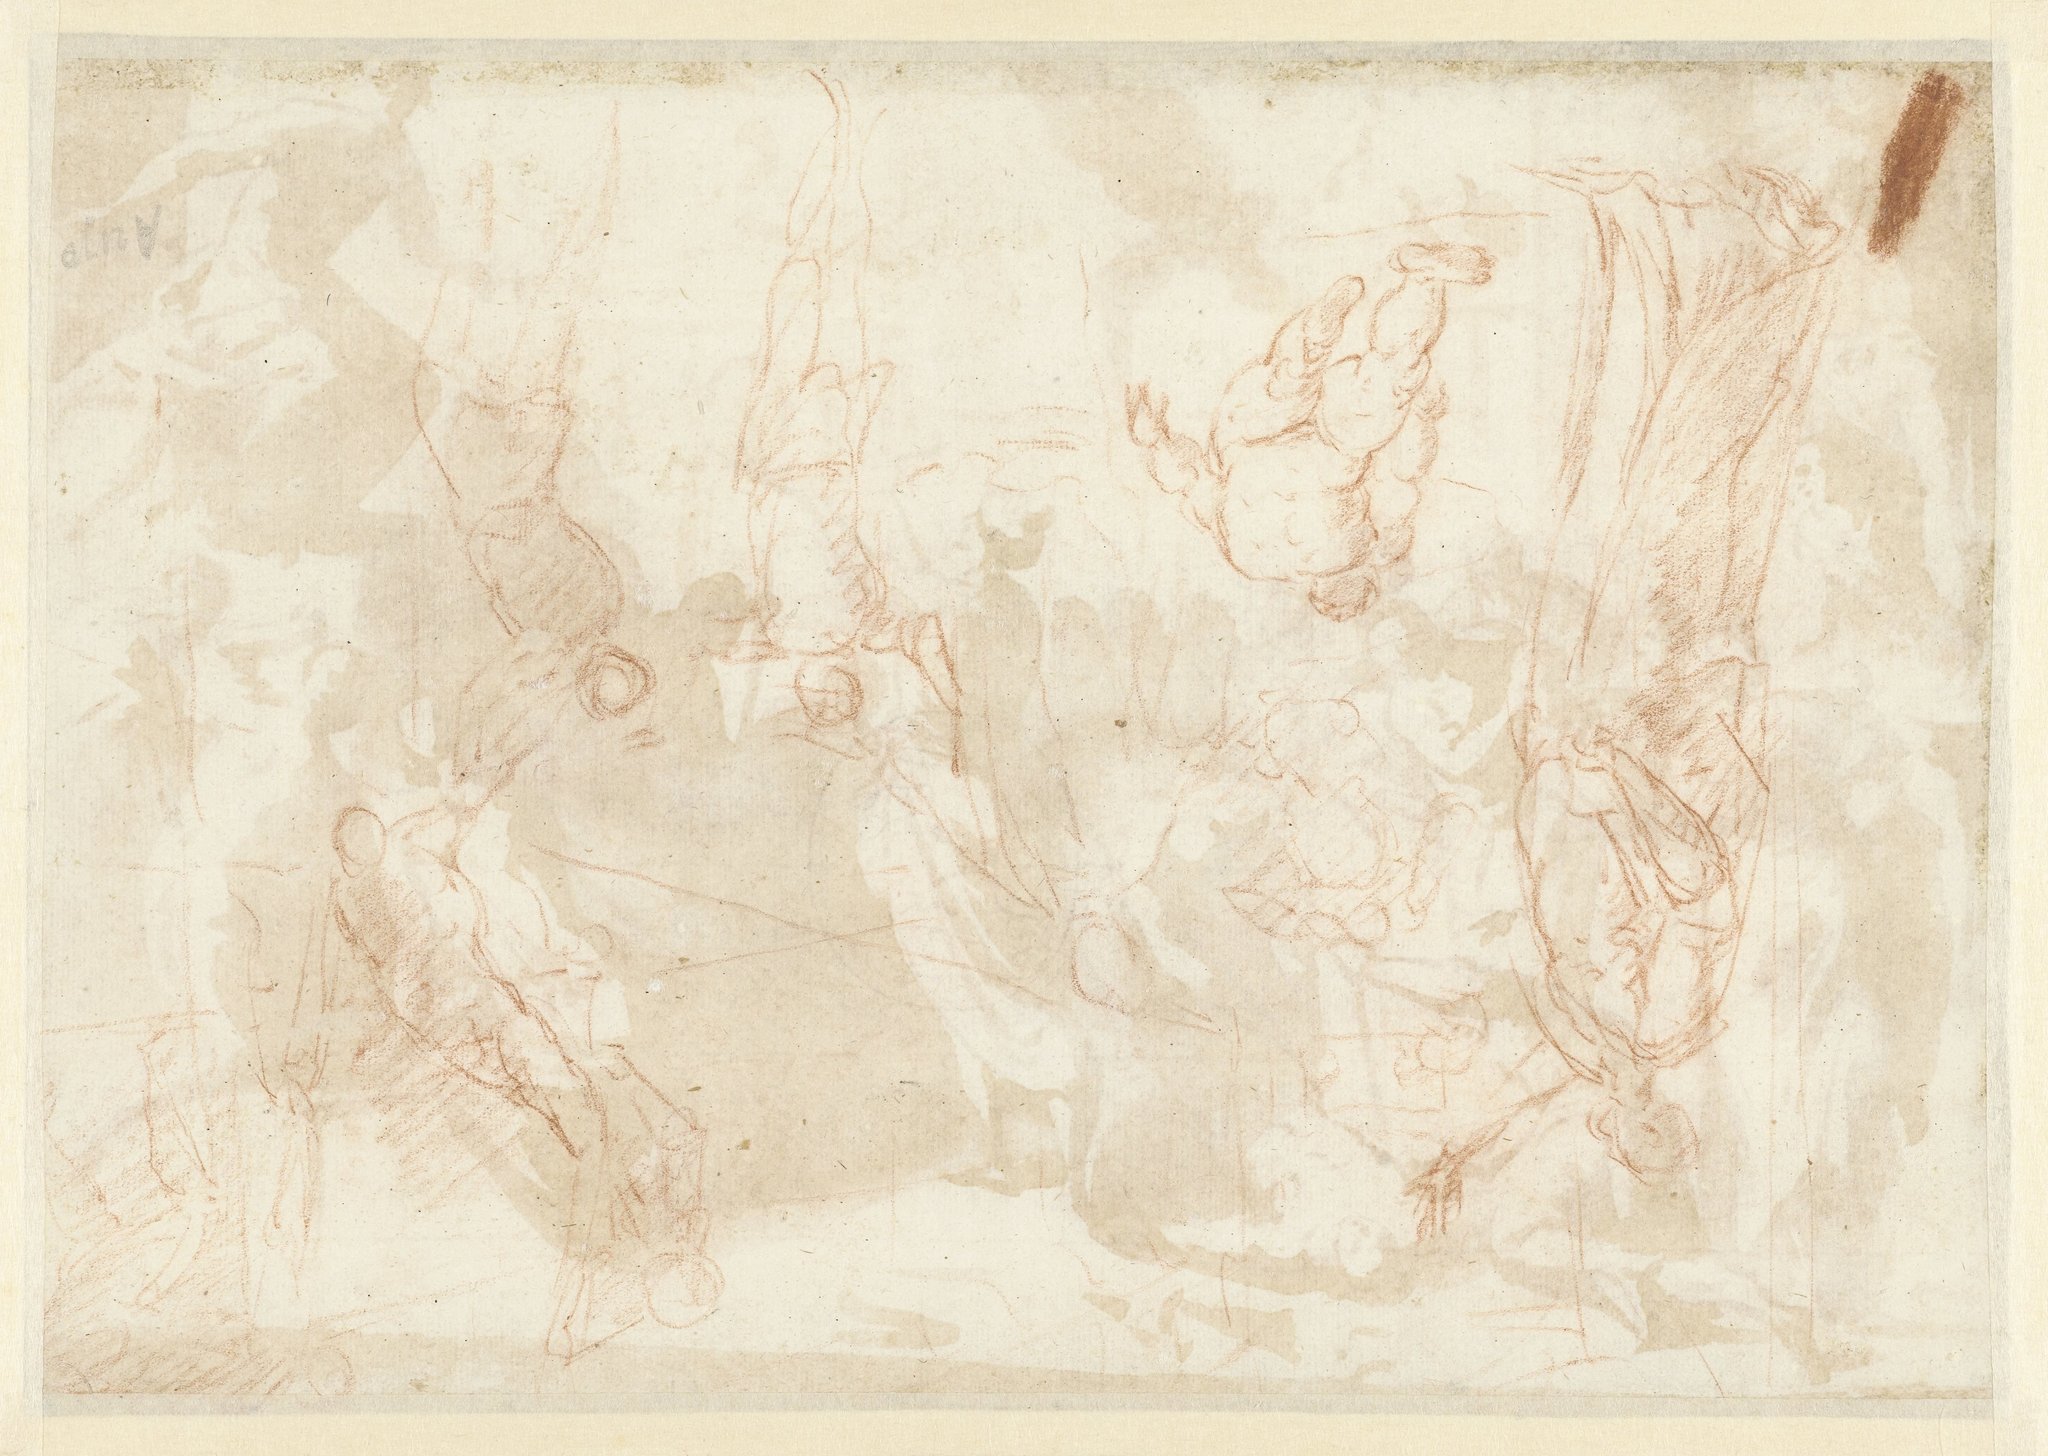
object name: drawing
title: Schetsen van H. Marcus die het leven van een slaaf redt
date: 1600-1699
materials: chalk, paper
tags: slavery; serfs and enslaved persons, st. mark rescues a slave from martyrdom by coming down from heaven; the instruments of torture break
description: Enige schetsen naar het schilderij van Tintoretto met de H. Markus die het leven van een slaafgemaakte redt.